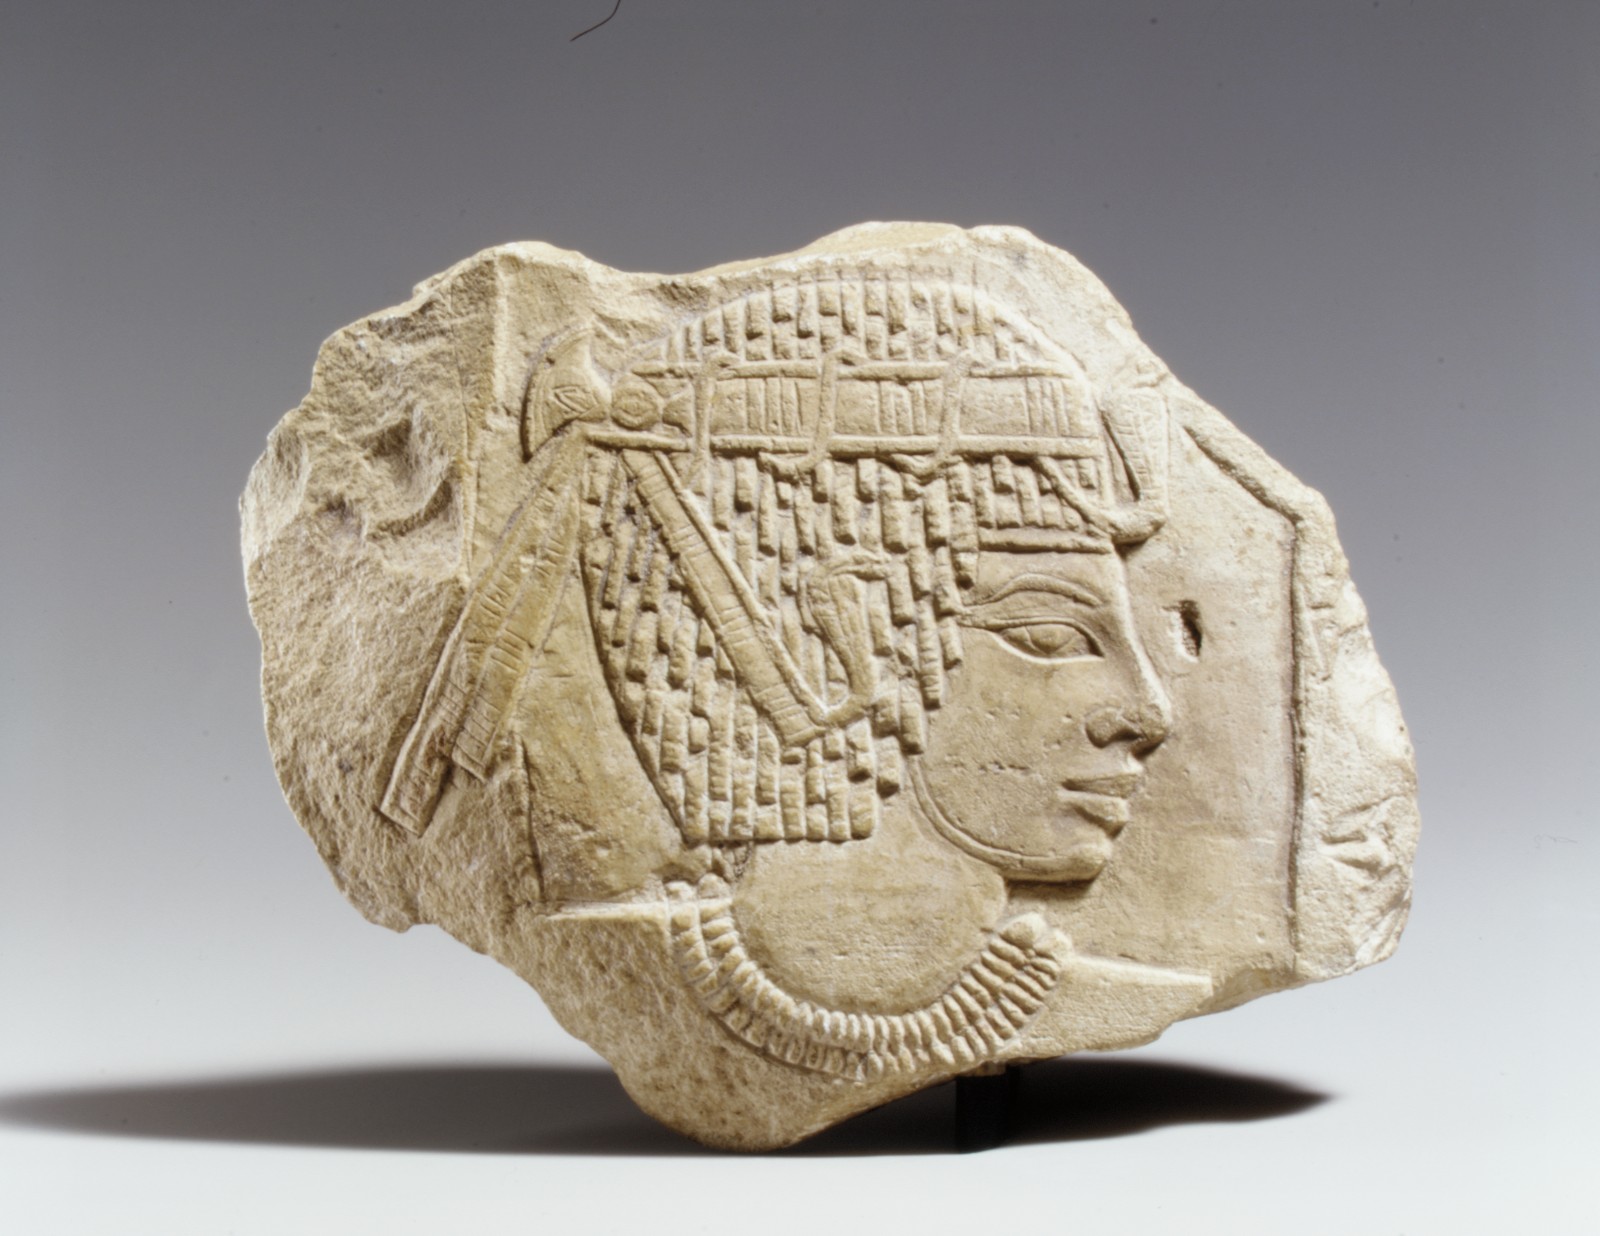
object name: trial piece, relief head of the king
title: Relief Trial Piece with the Head of the King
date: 1390-1352 BCE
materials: limestone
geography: egypt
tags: kings,heads